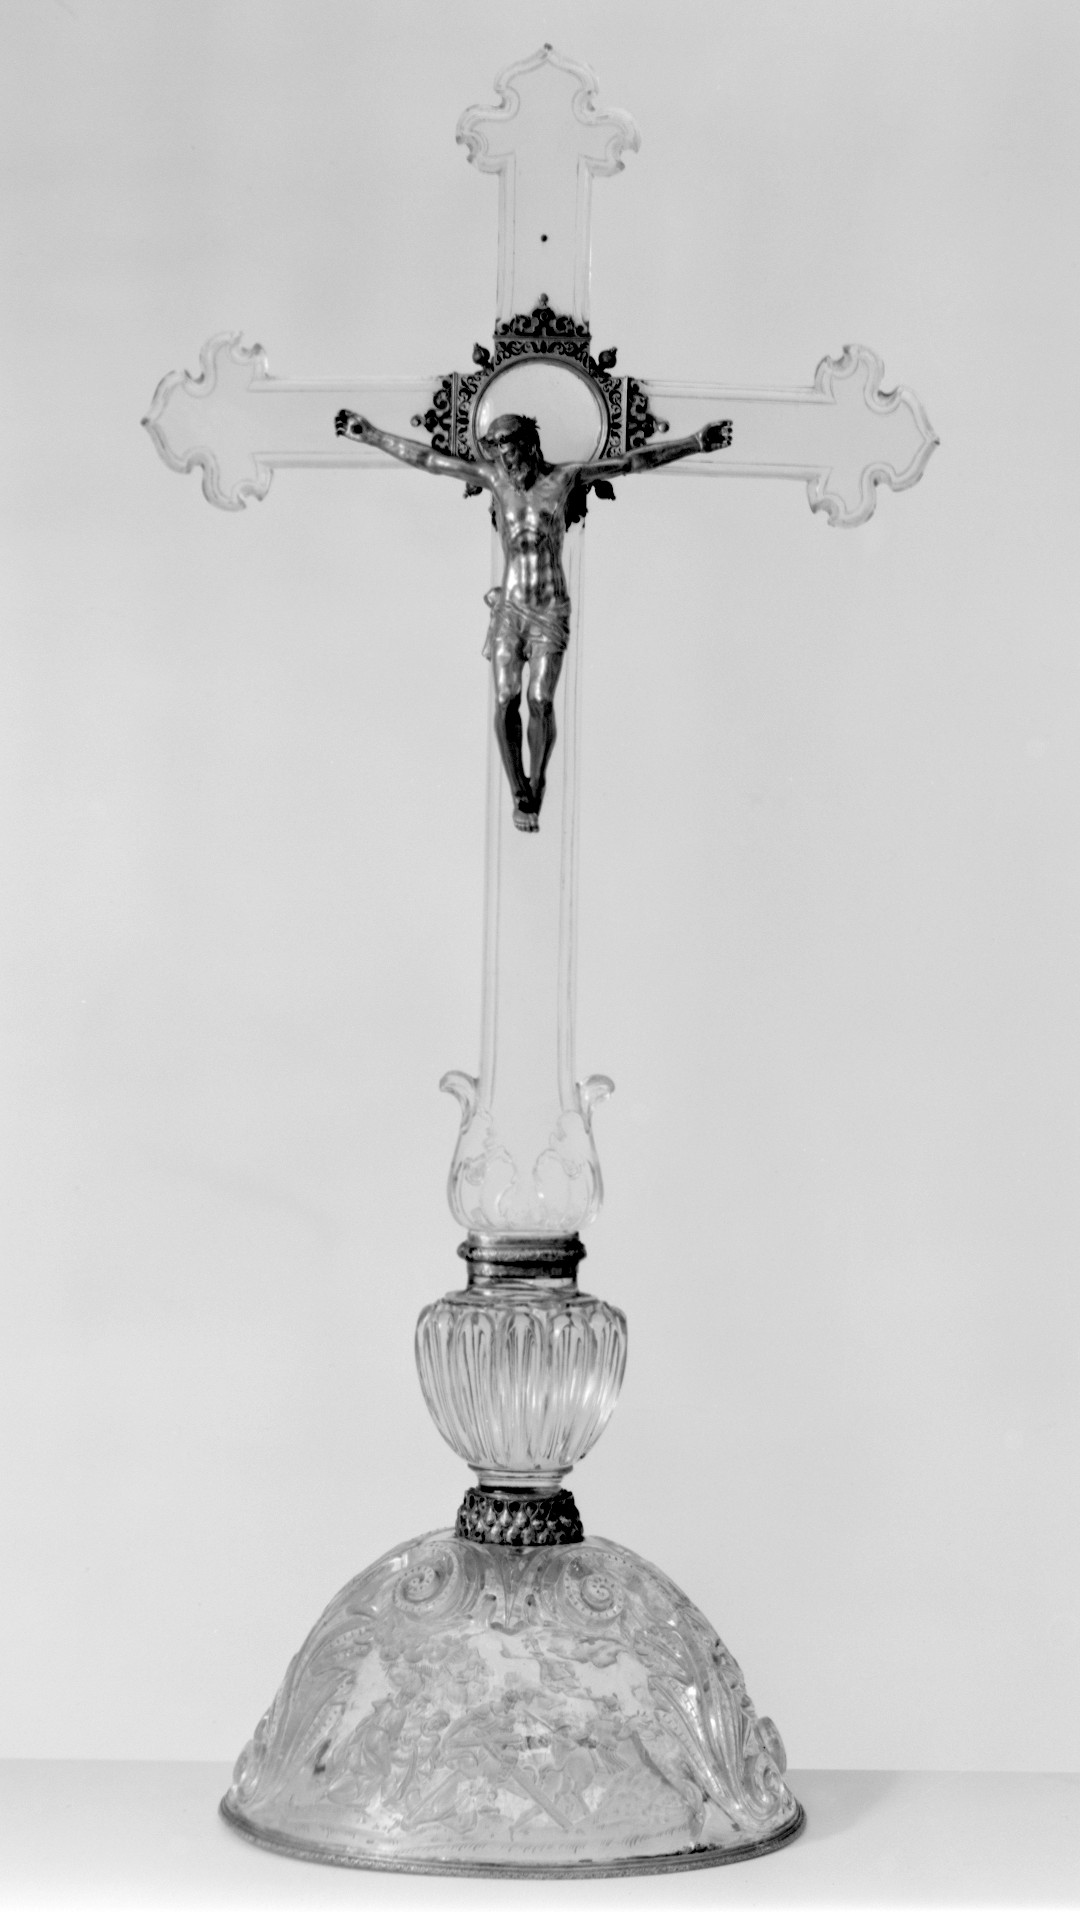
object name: crucifix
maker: the saracchi, milan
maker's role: maker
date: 1501-1600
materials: gilt, metal, quartz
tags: christ,cross,crucifixion